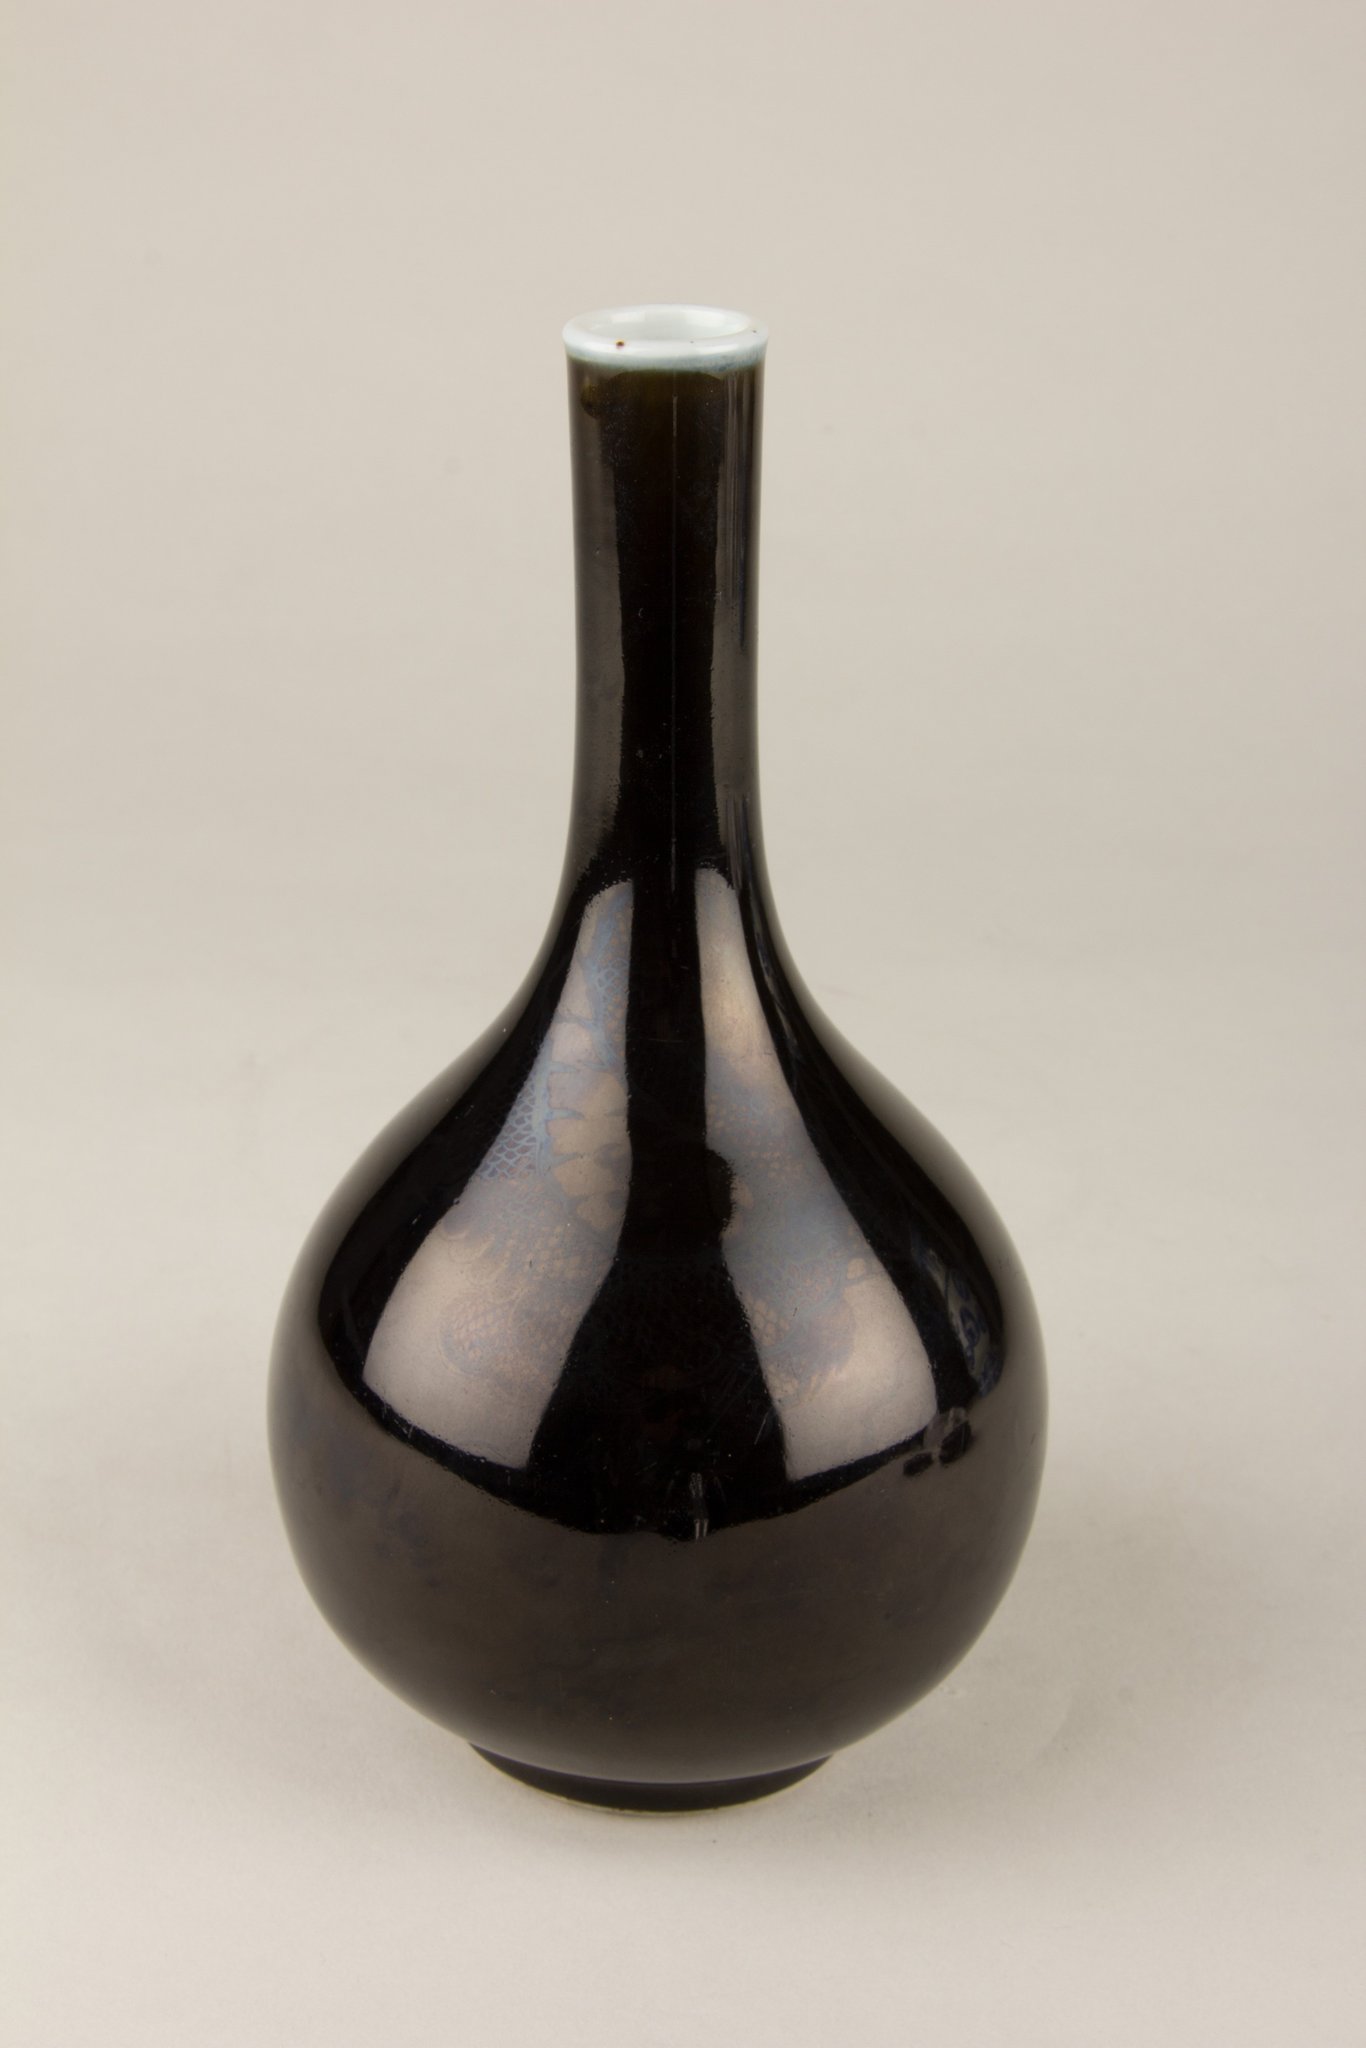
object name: vase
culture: chinese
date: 1662-1722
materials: glaze, porcelain